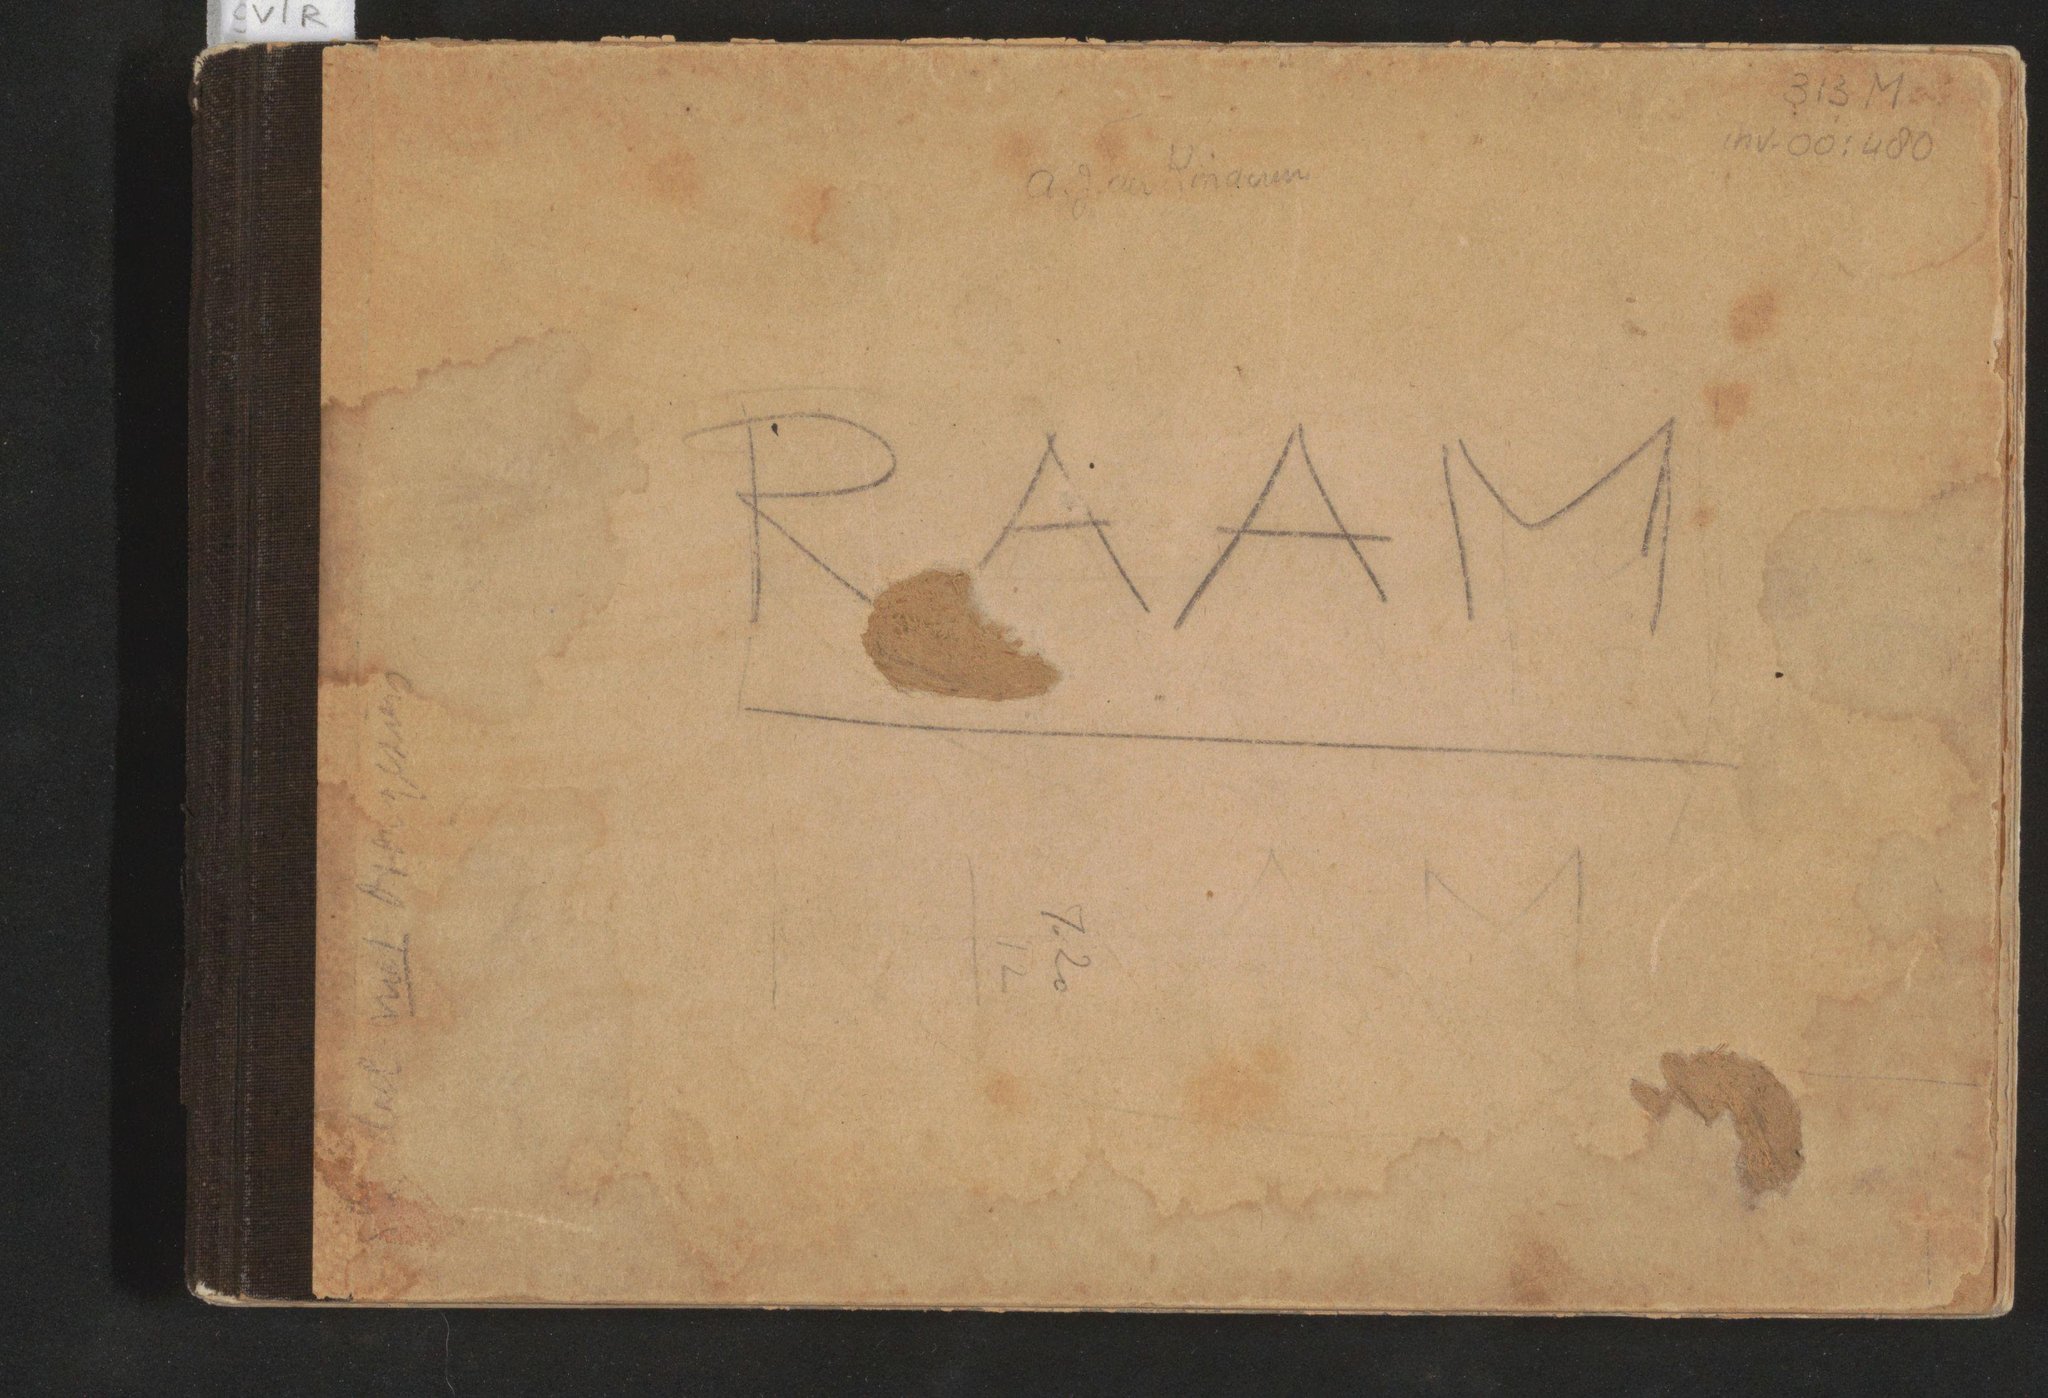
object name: sketchbook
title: Schetsboek met 45 bladen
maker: antoon derkinderen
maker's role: draughtsman, painter, print maker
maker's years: 1859-1925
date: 1900-1903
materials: cardboard, chalk, linen, paper, pencil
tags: window, zodiac; the twelve zodiacal signs together, gods ~ classical mythology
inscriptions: inscription: ‘[...]/ RAAM/ [...]oe Wel[...]/ Co[...] horst/ kever/ walli/ [...]’, collector's mark: Lugt 2228a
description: Schetsboek bestaande uit 45 bladen met voornamelijk ontwerpen voor glas-in-loodramen voor de Kamer van Koophandel in de Beurs van Berlage te Amsterdam met voorstellingen van mythologische goden en figuren, sterrenbeelden en allegorieën in medaillons. Op de achterzijde van de band een potloodstudie, vermoedelijk ook van een venster.